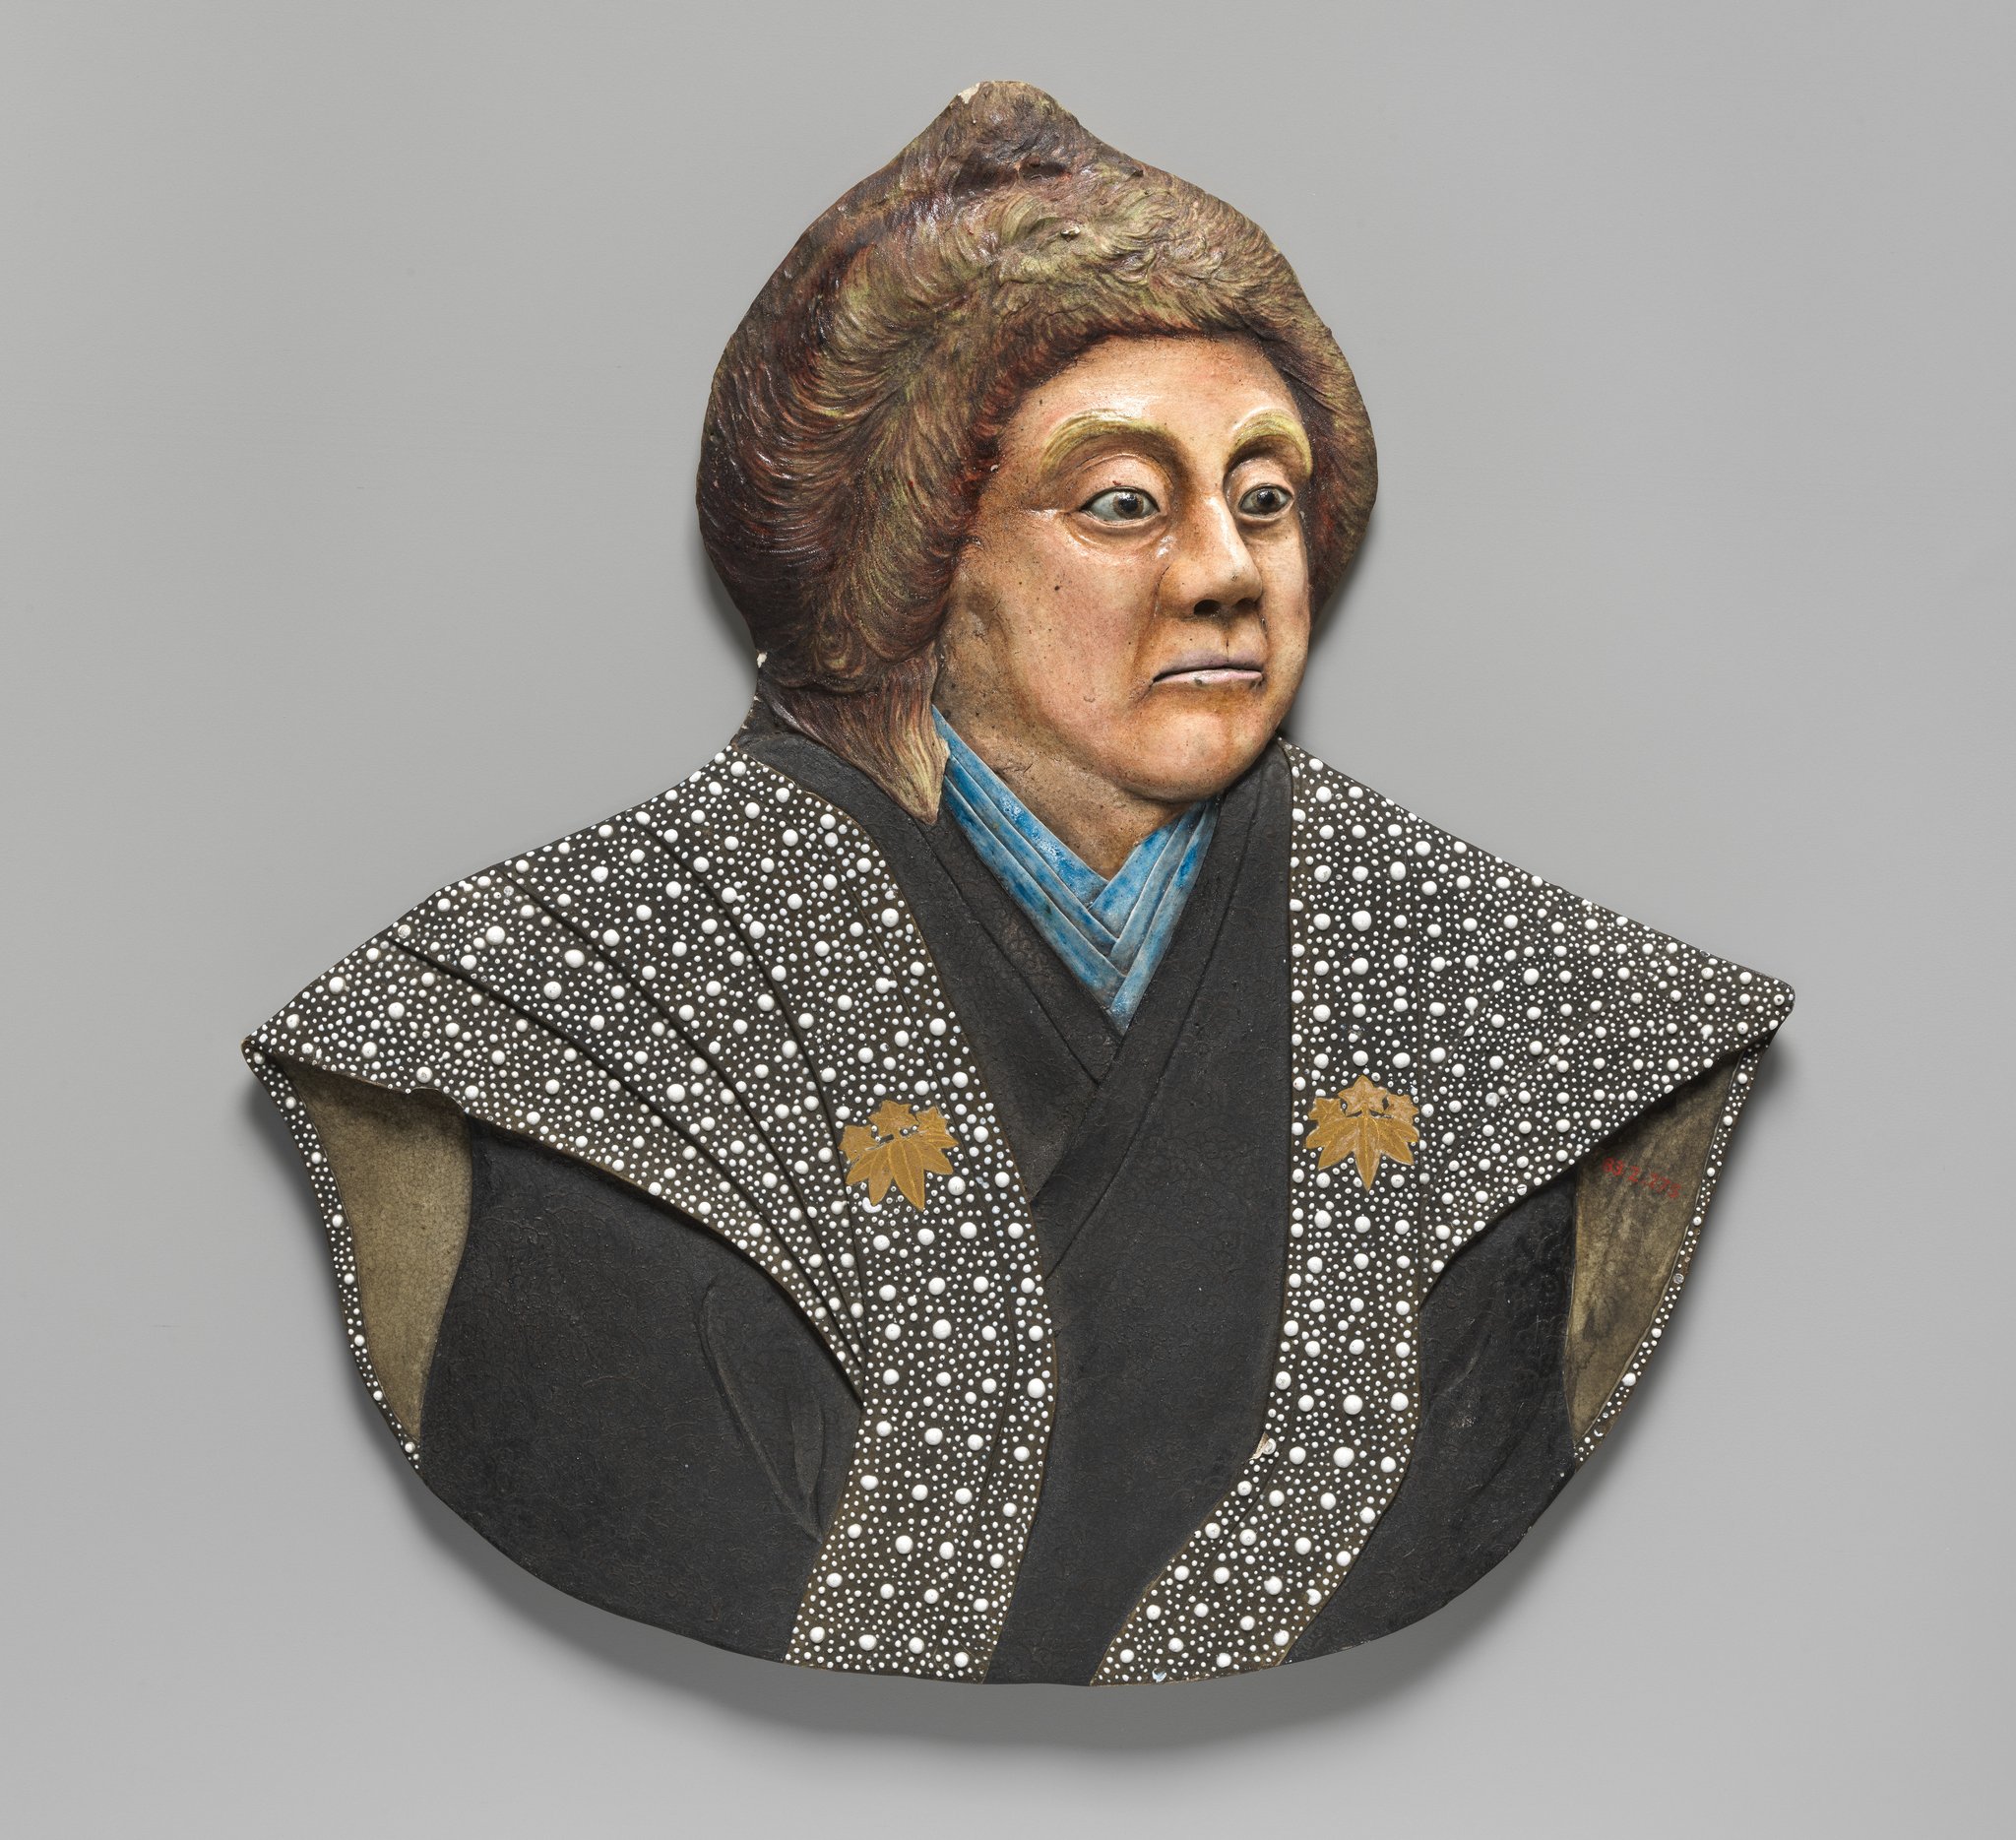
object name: bust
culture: japanese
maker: miyagawa kozan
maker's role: artist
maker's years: 1842-1916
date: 1865-1883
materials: porcelain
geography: japan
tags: men,portraits